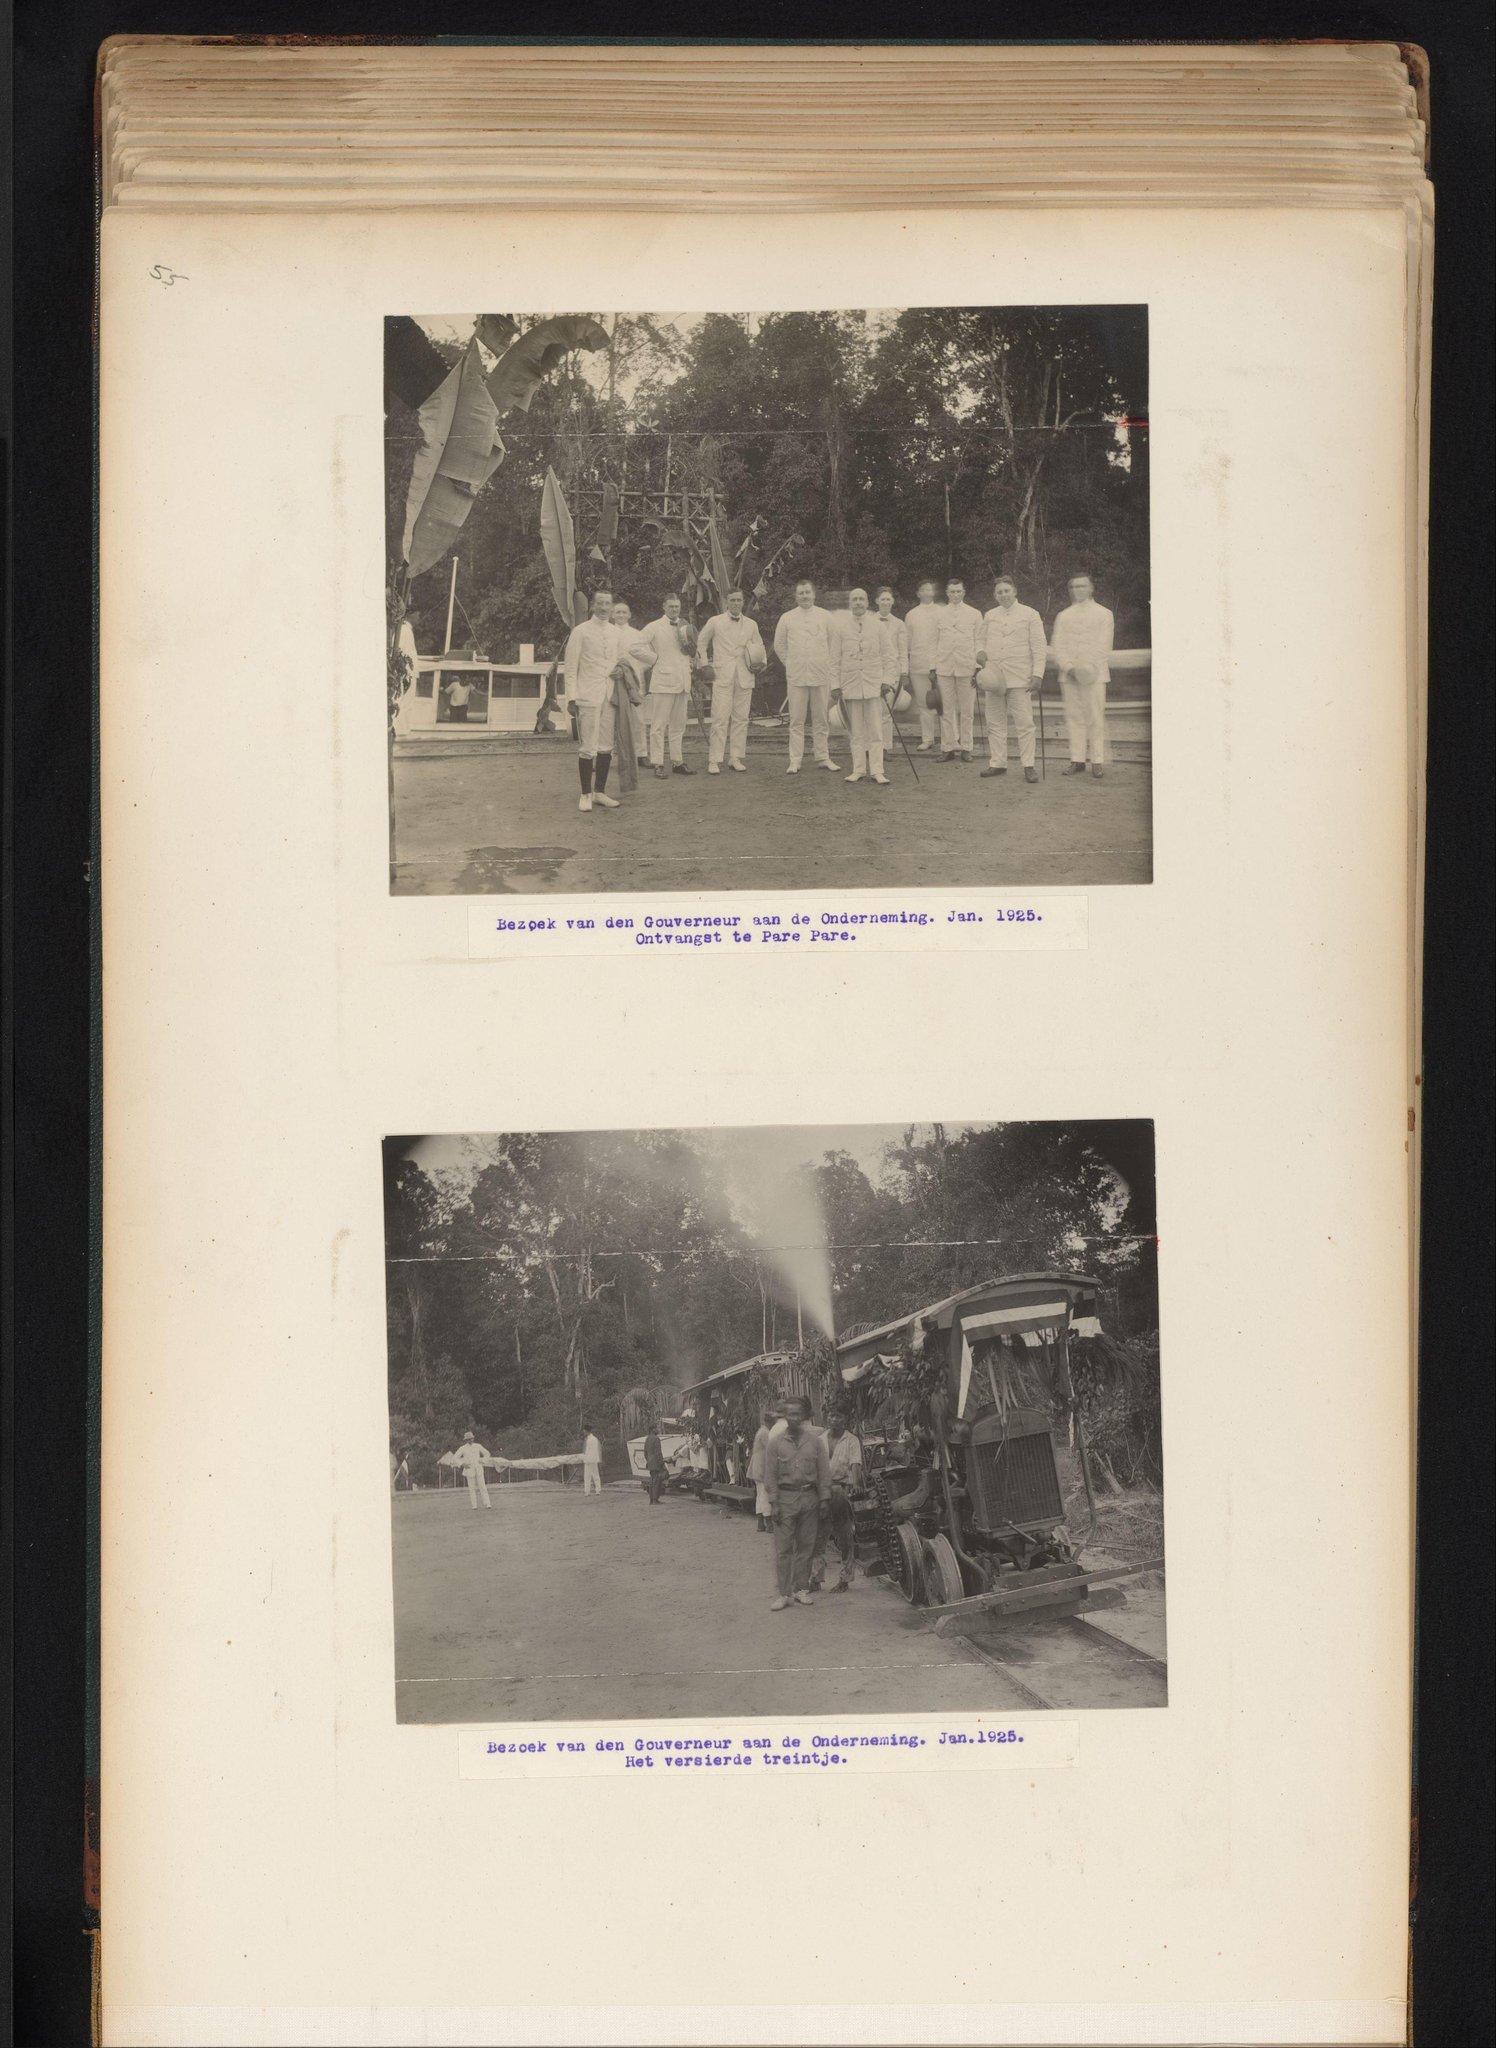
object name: album leaf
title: Bezoek van de gouverneur aan de onderneming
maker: Anonymous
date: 1901-1925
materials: cardboard, photographic support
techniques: gelatin silver print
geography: sumatra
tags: plantation, colonial governor, (non-fruit) products of plants or trees: rubber, sumatra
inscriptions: inscription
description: Blad met twee foto's van het bezoek van de gouverneur van de Oostkust van Sumatra aan de onderneming te Pare Pare, januari 1925. Onder de foto's etiketten met onderschriften. Onderdeel van het fotoalbum over de plantages Brussel en Pernantian van de Sumatra Caoutchouc Maatschappij op de Oostkust van Sumatra in de jaren 1910-1935.